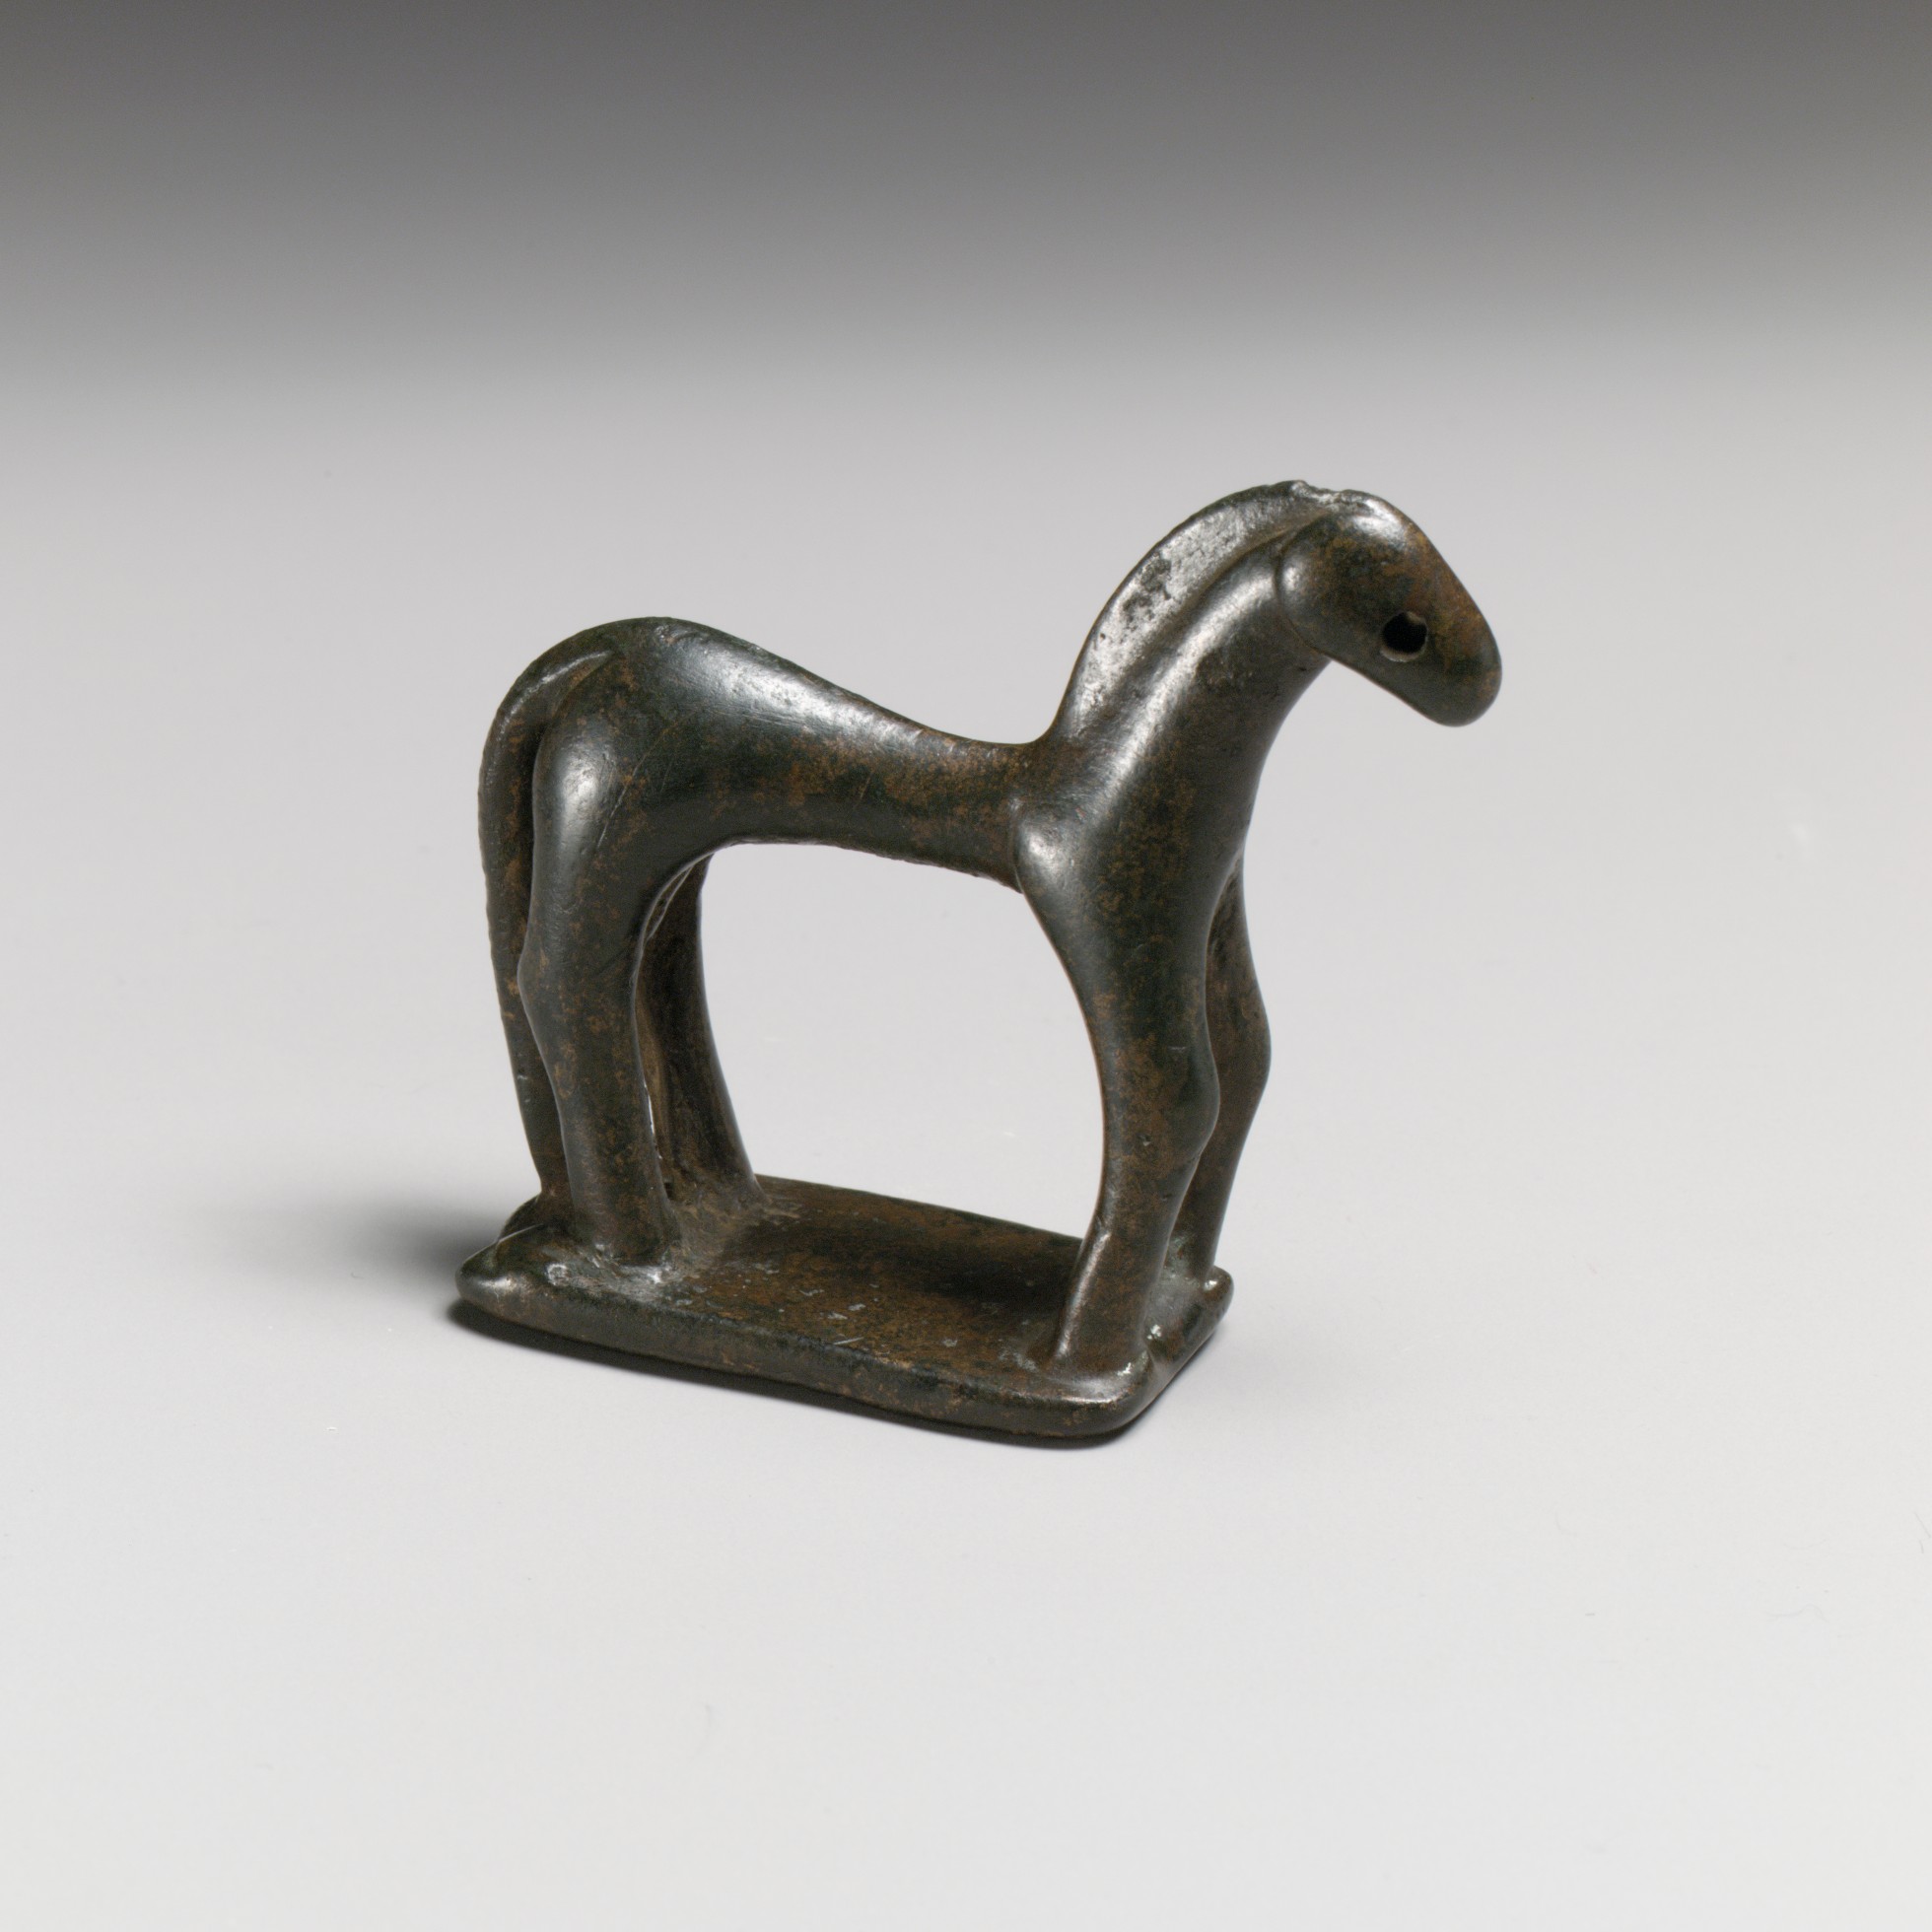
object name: statuette of a horse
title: Bronze statuette of a horse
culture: greek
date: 800-701 BCE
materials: bronze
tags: horses